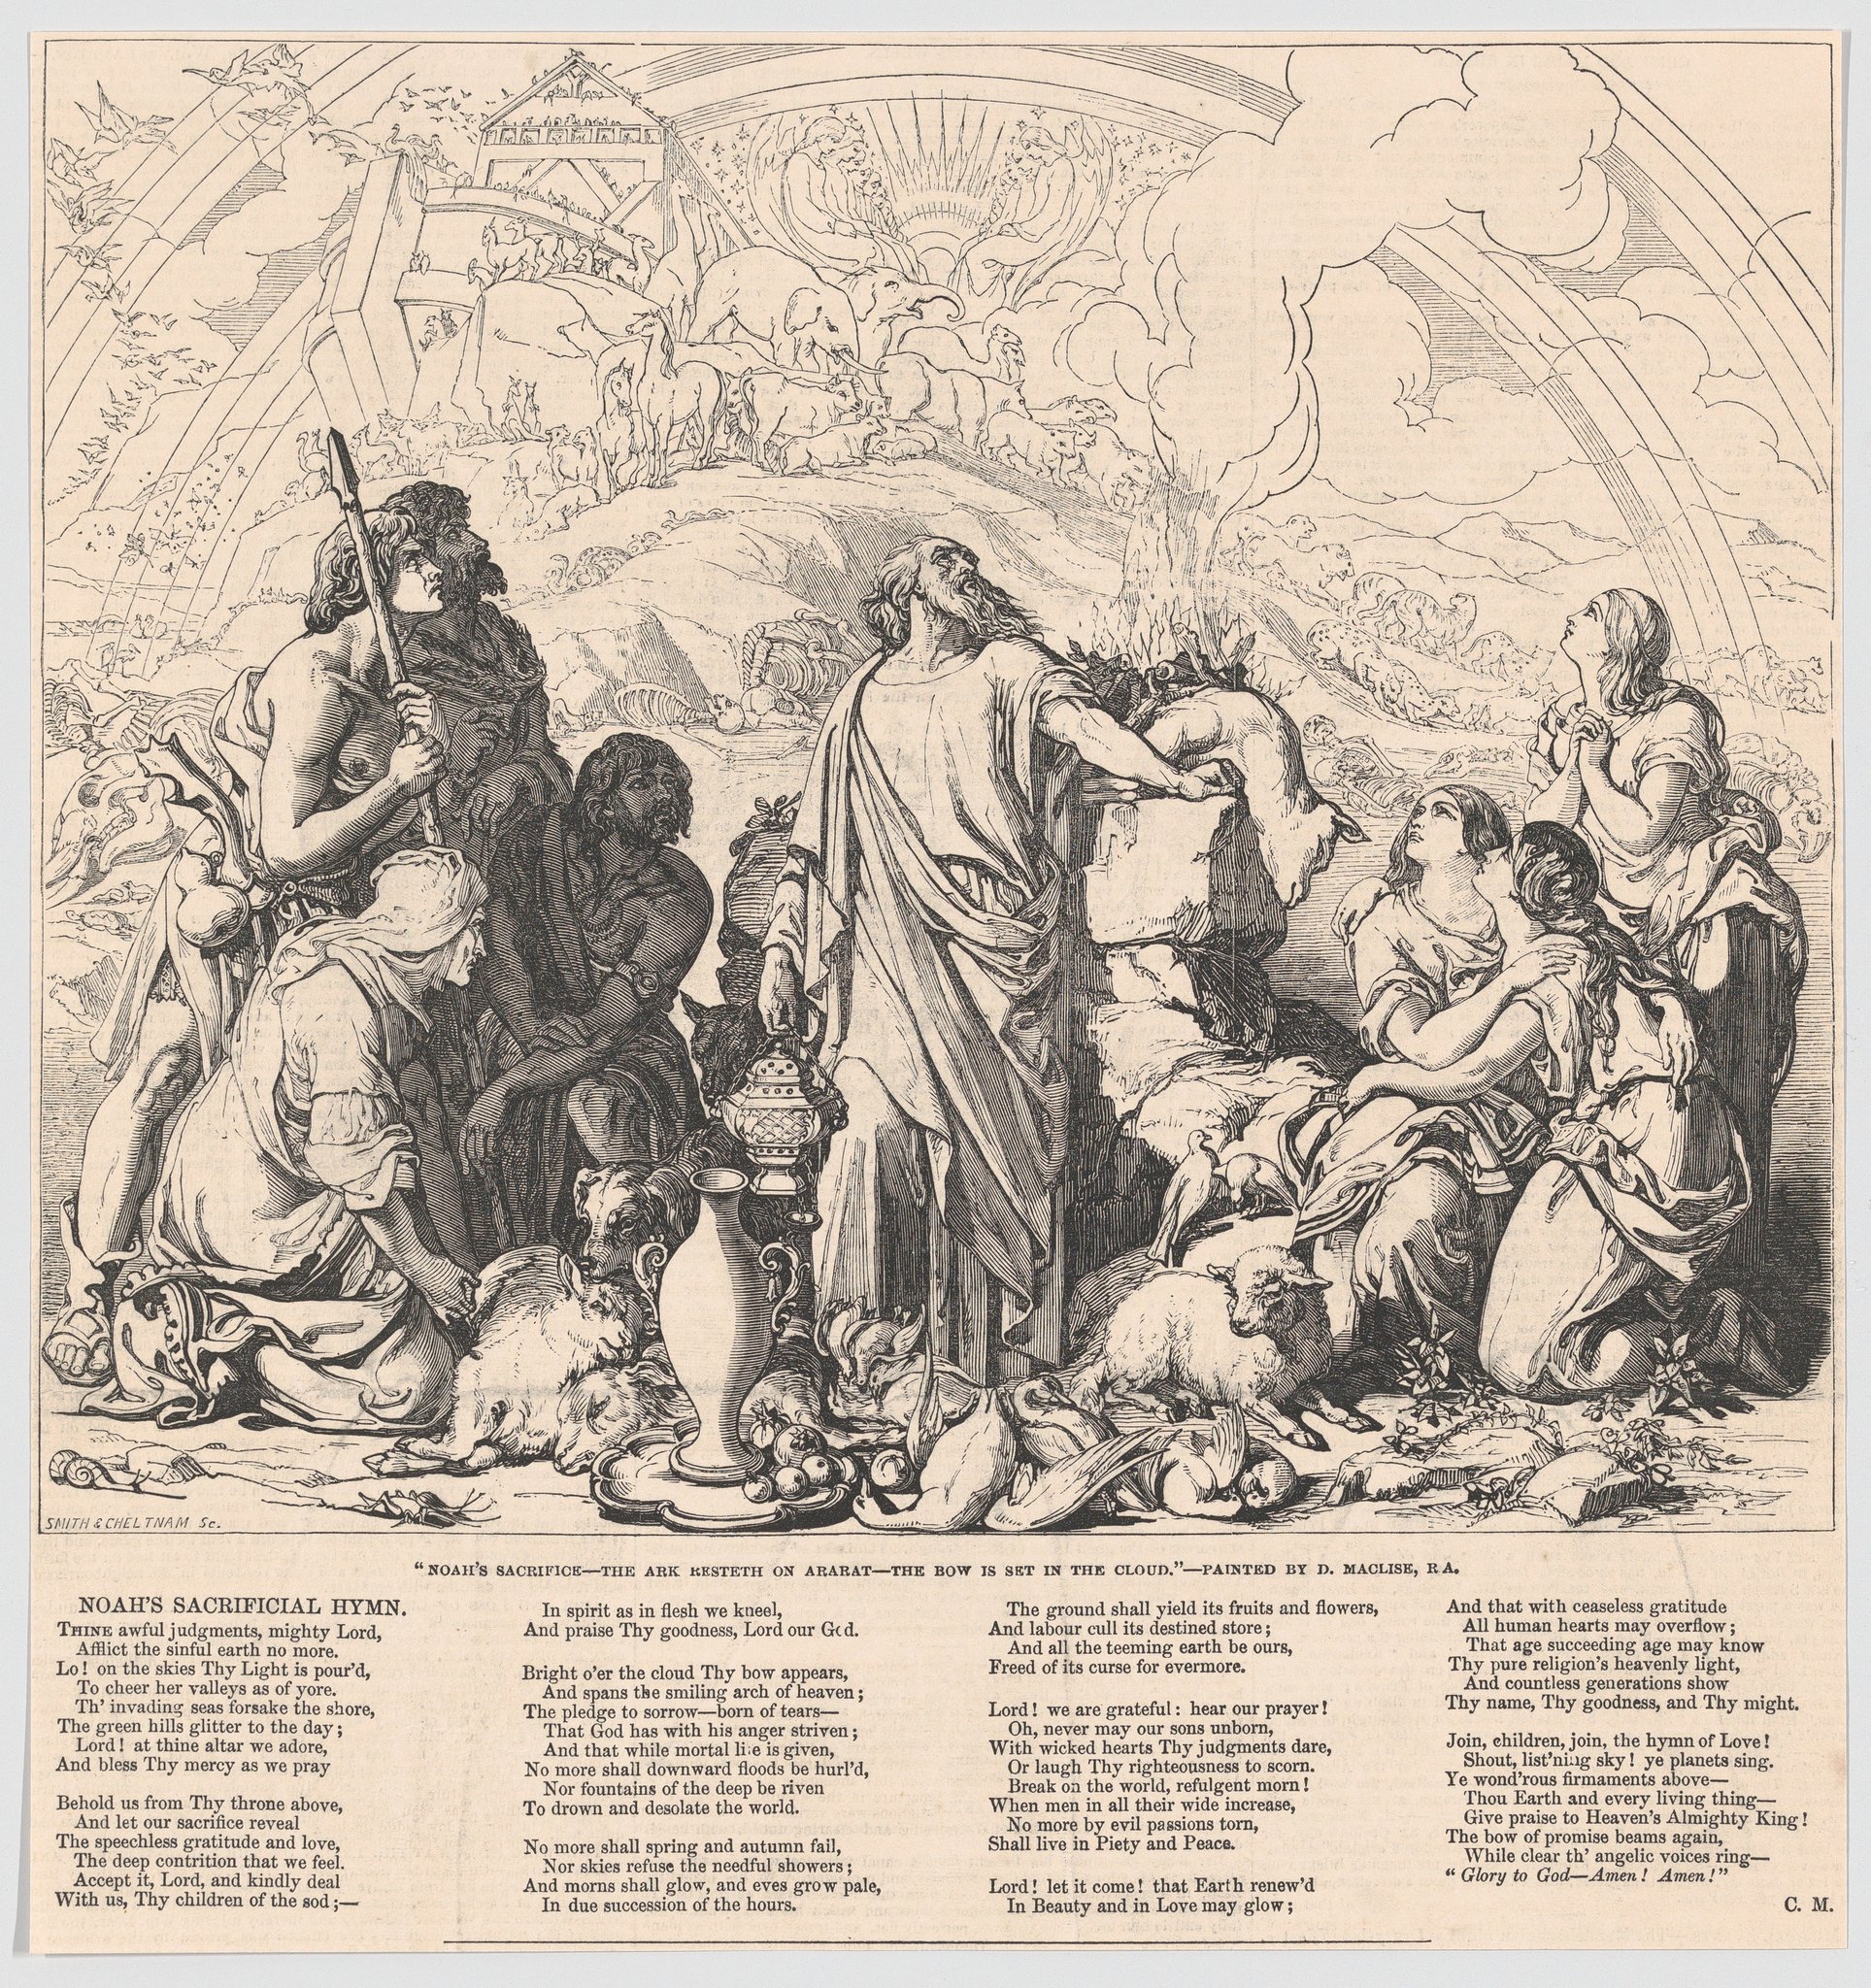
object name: print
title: Noah's Sacrifice, from "Illustrated London News"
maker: charles cheltnam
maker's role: engraver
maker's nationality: british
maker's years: 1848-1857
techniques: engraving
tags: birds,men,women,lambs